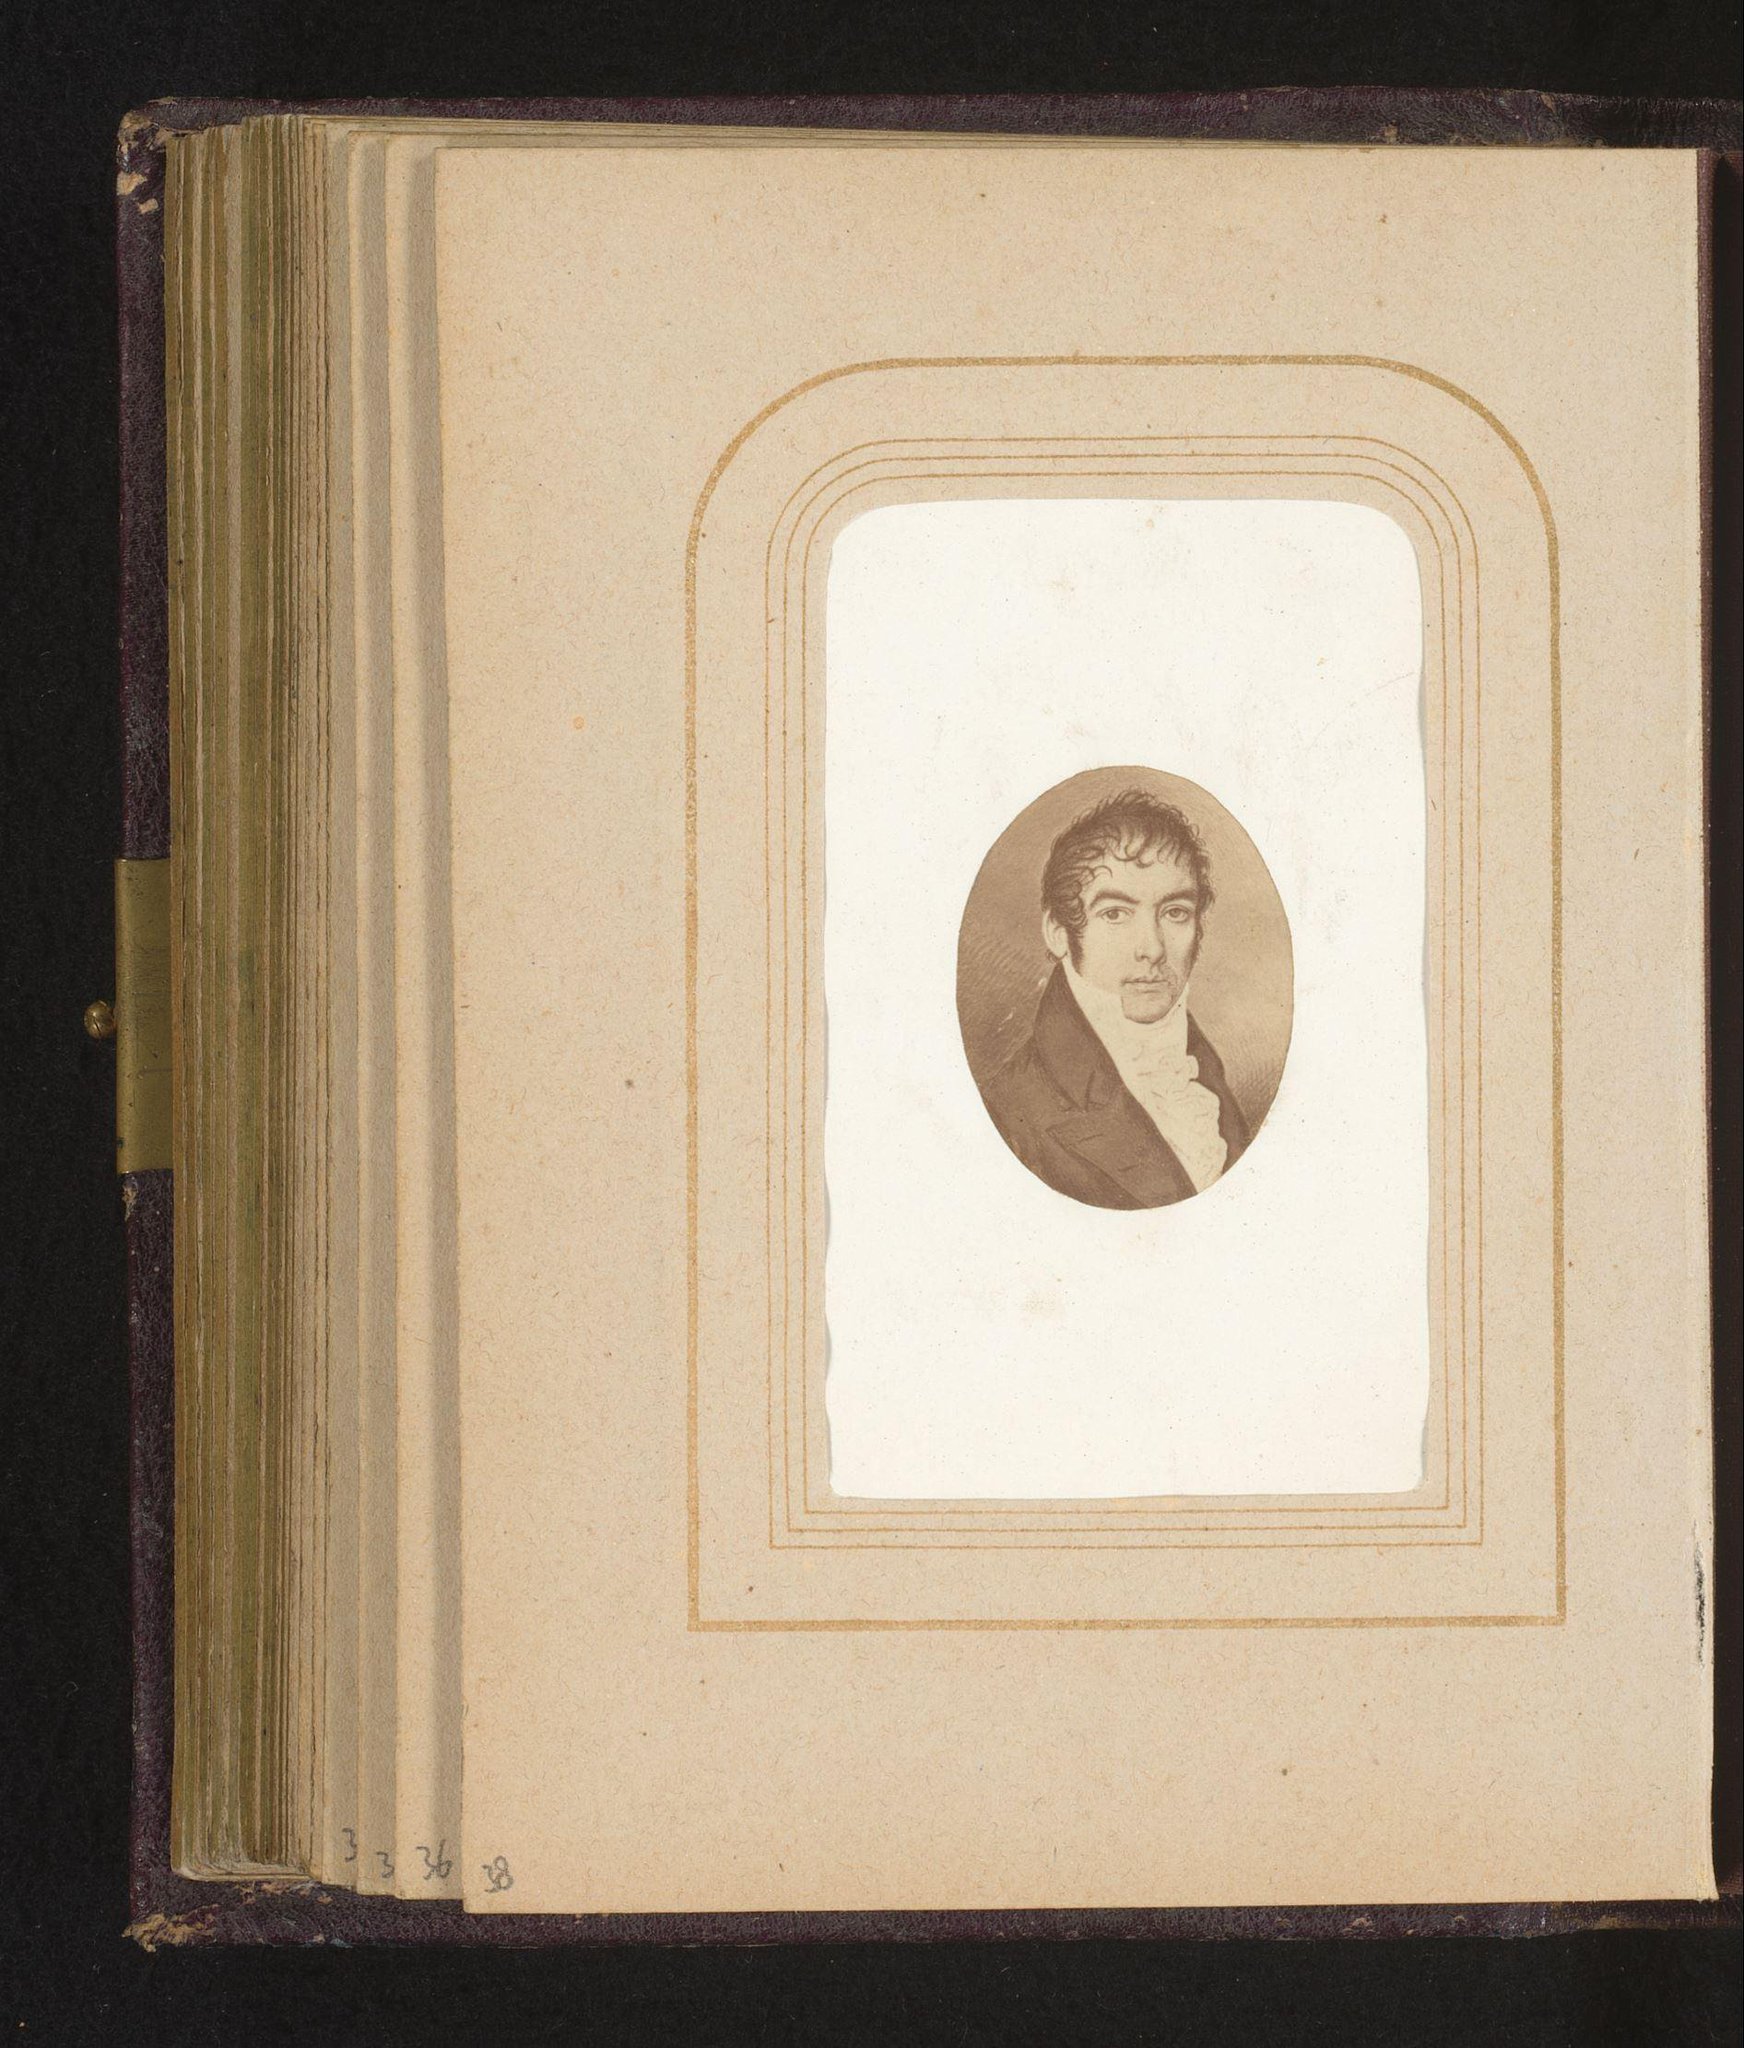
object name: photograph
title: Fotoreproductie van een getekend portret van een jongeman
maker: Anonymous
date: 1860-1900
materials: cardboard, photographic support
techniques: albumen print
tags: youth, adolescent